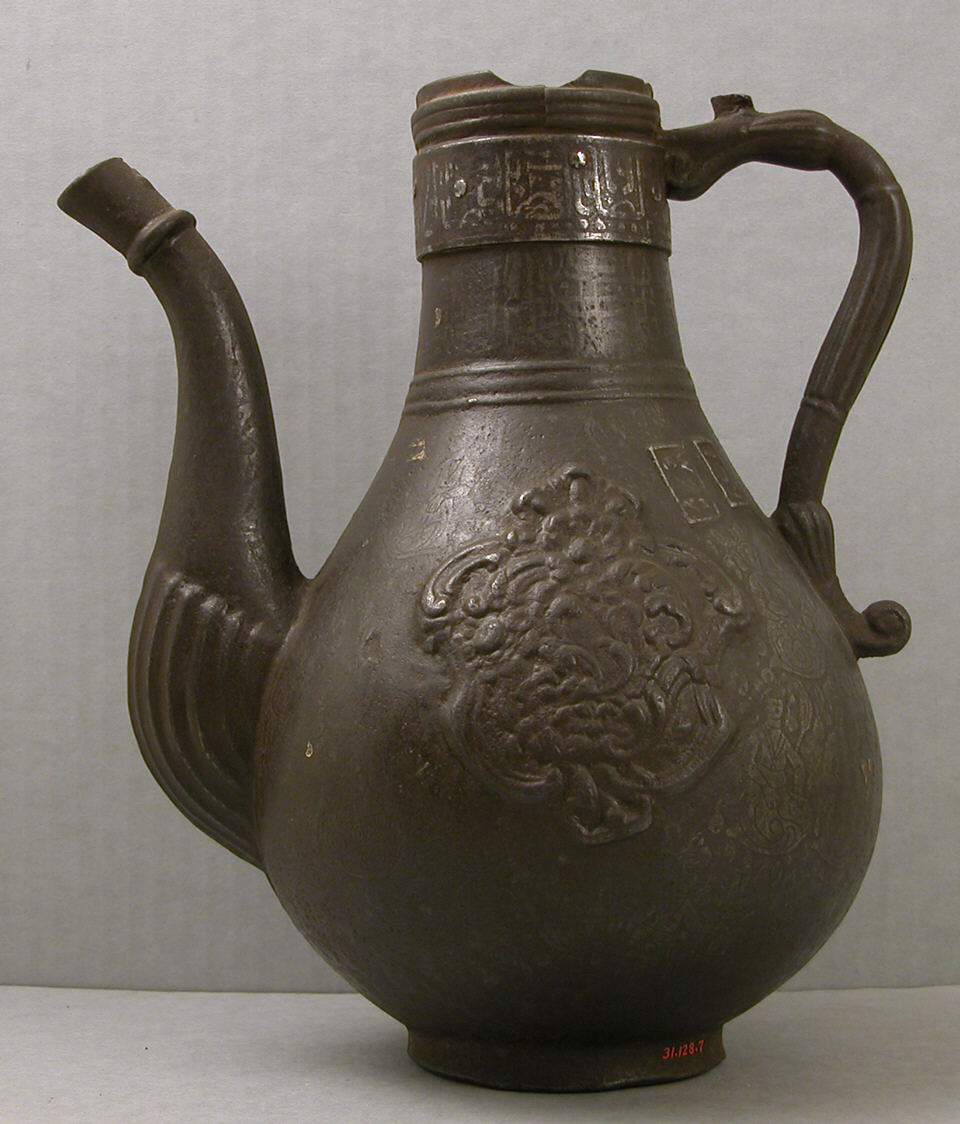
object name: ewer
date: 1701-1800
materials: iron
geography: india